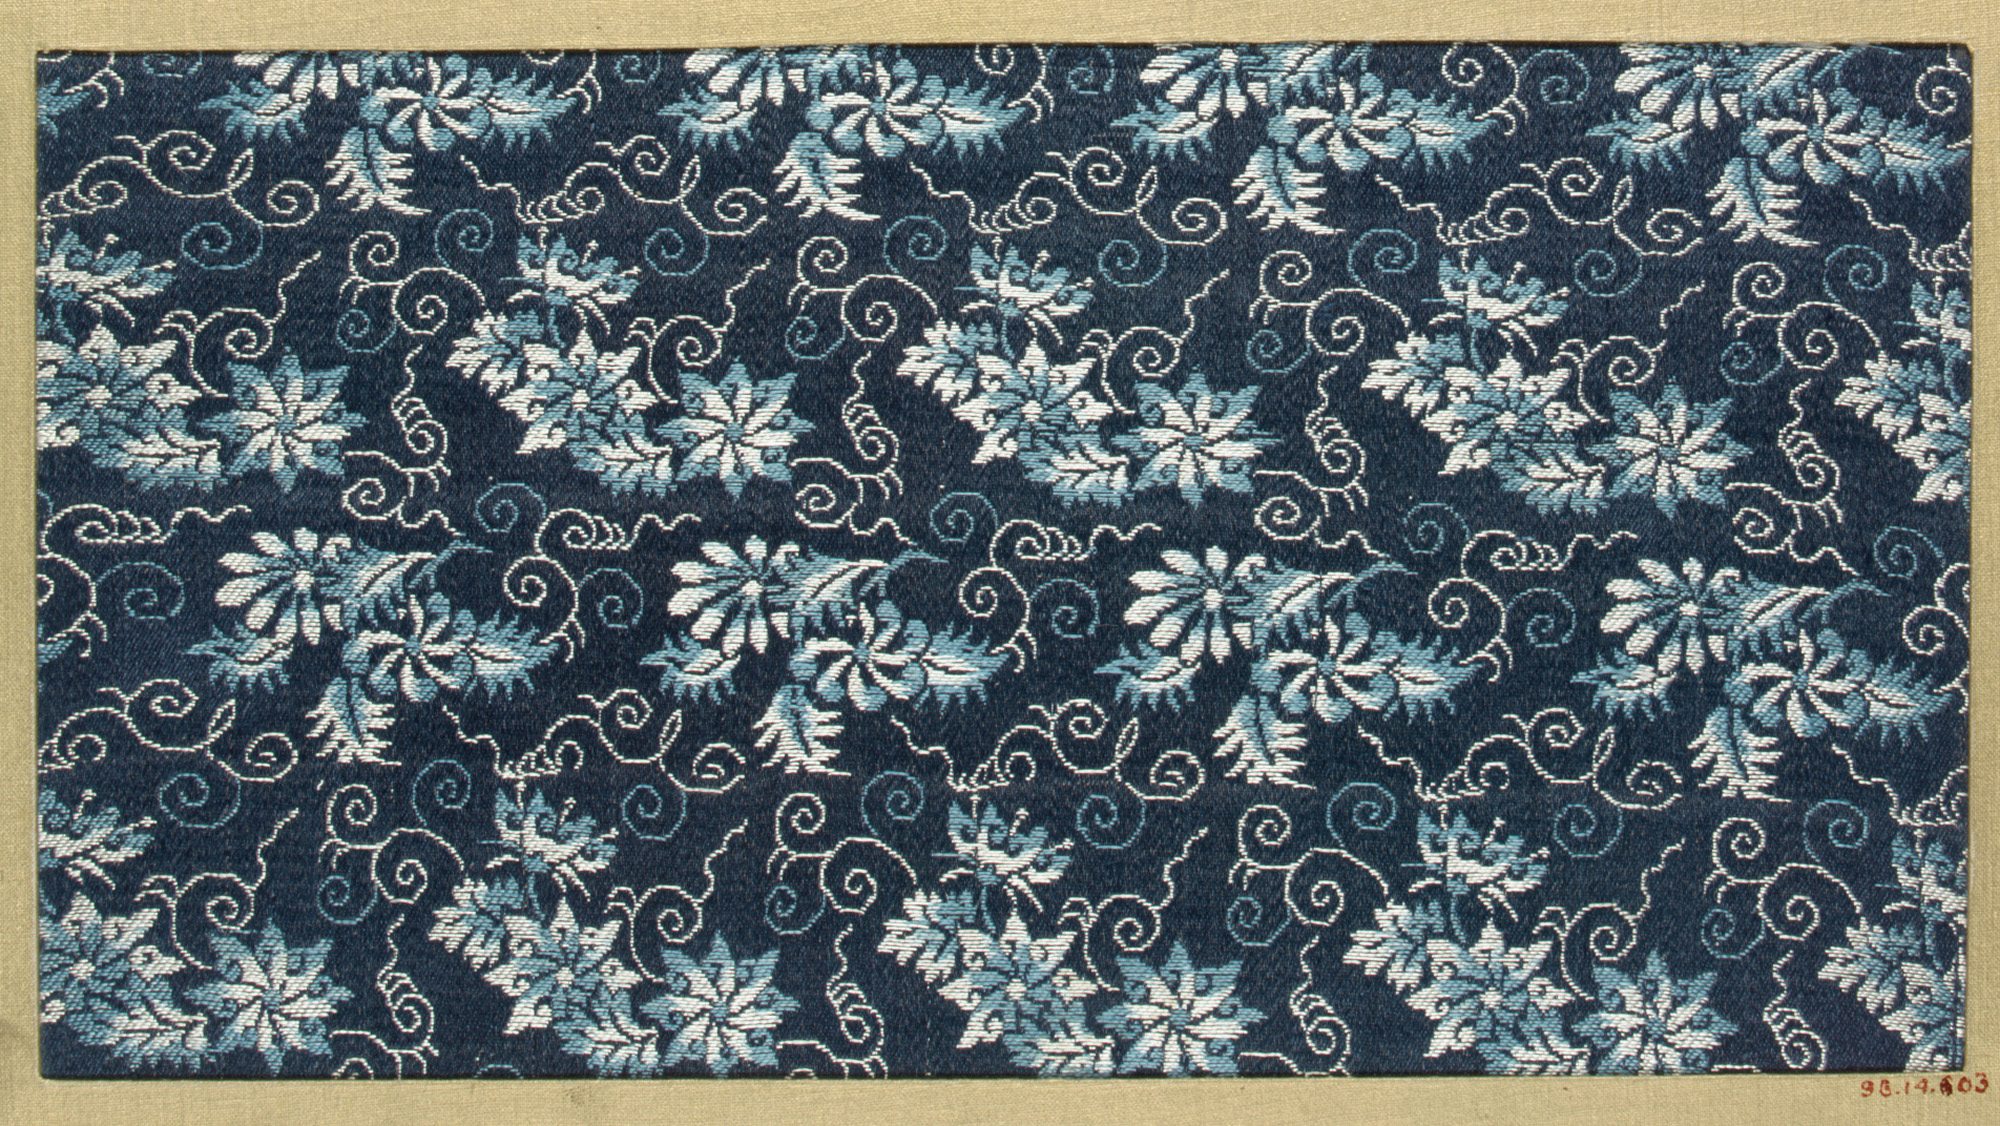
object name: piece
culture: japanese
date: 1701-1900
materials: silk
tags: leaves